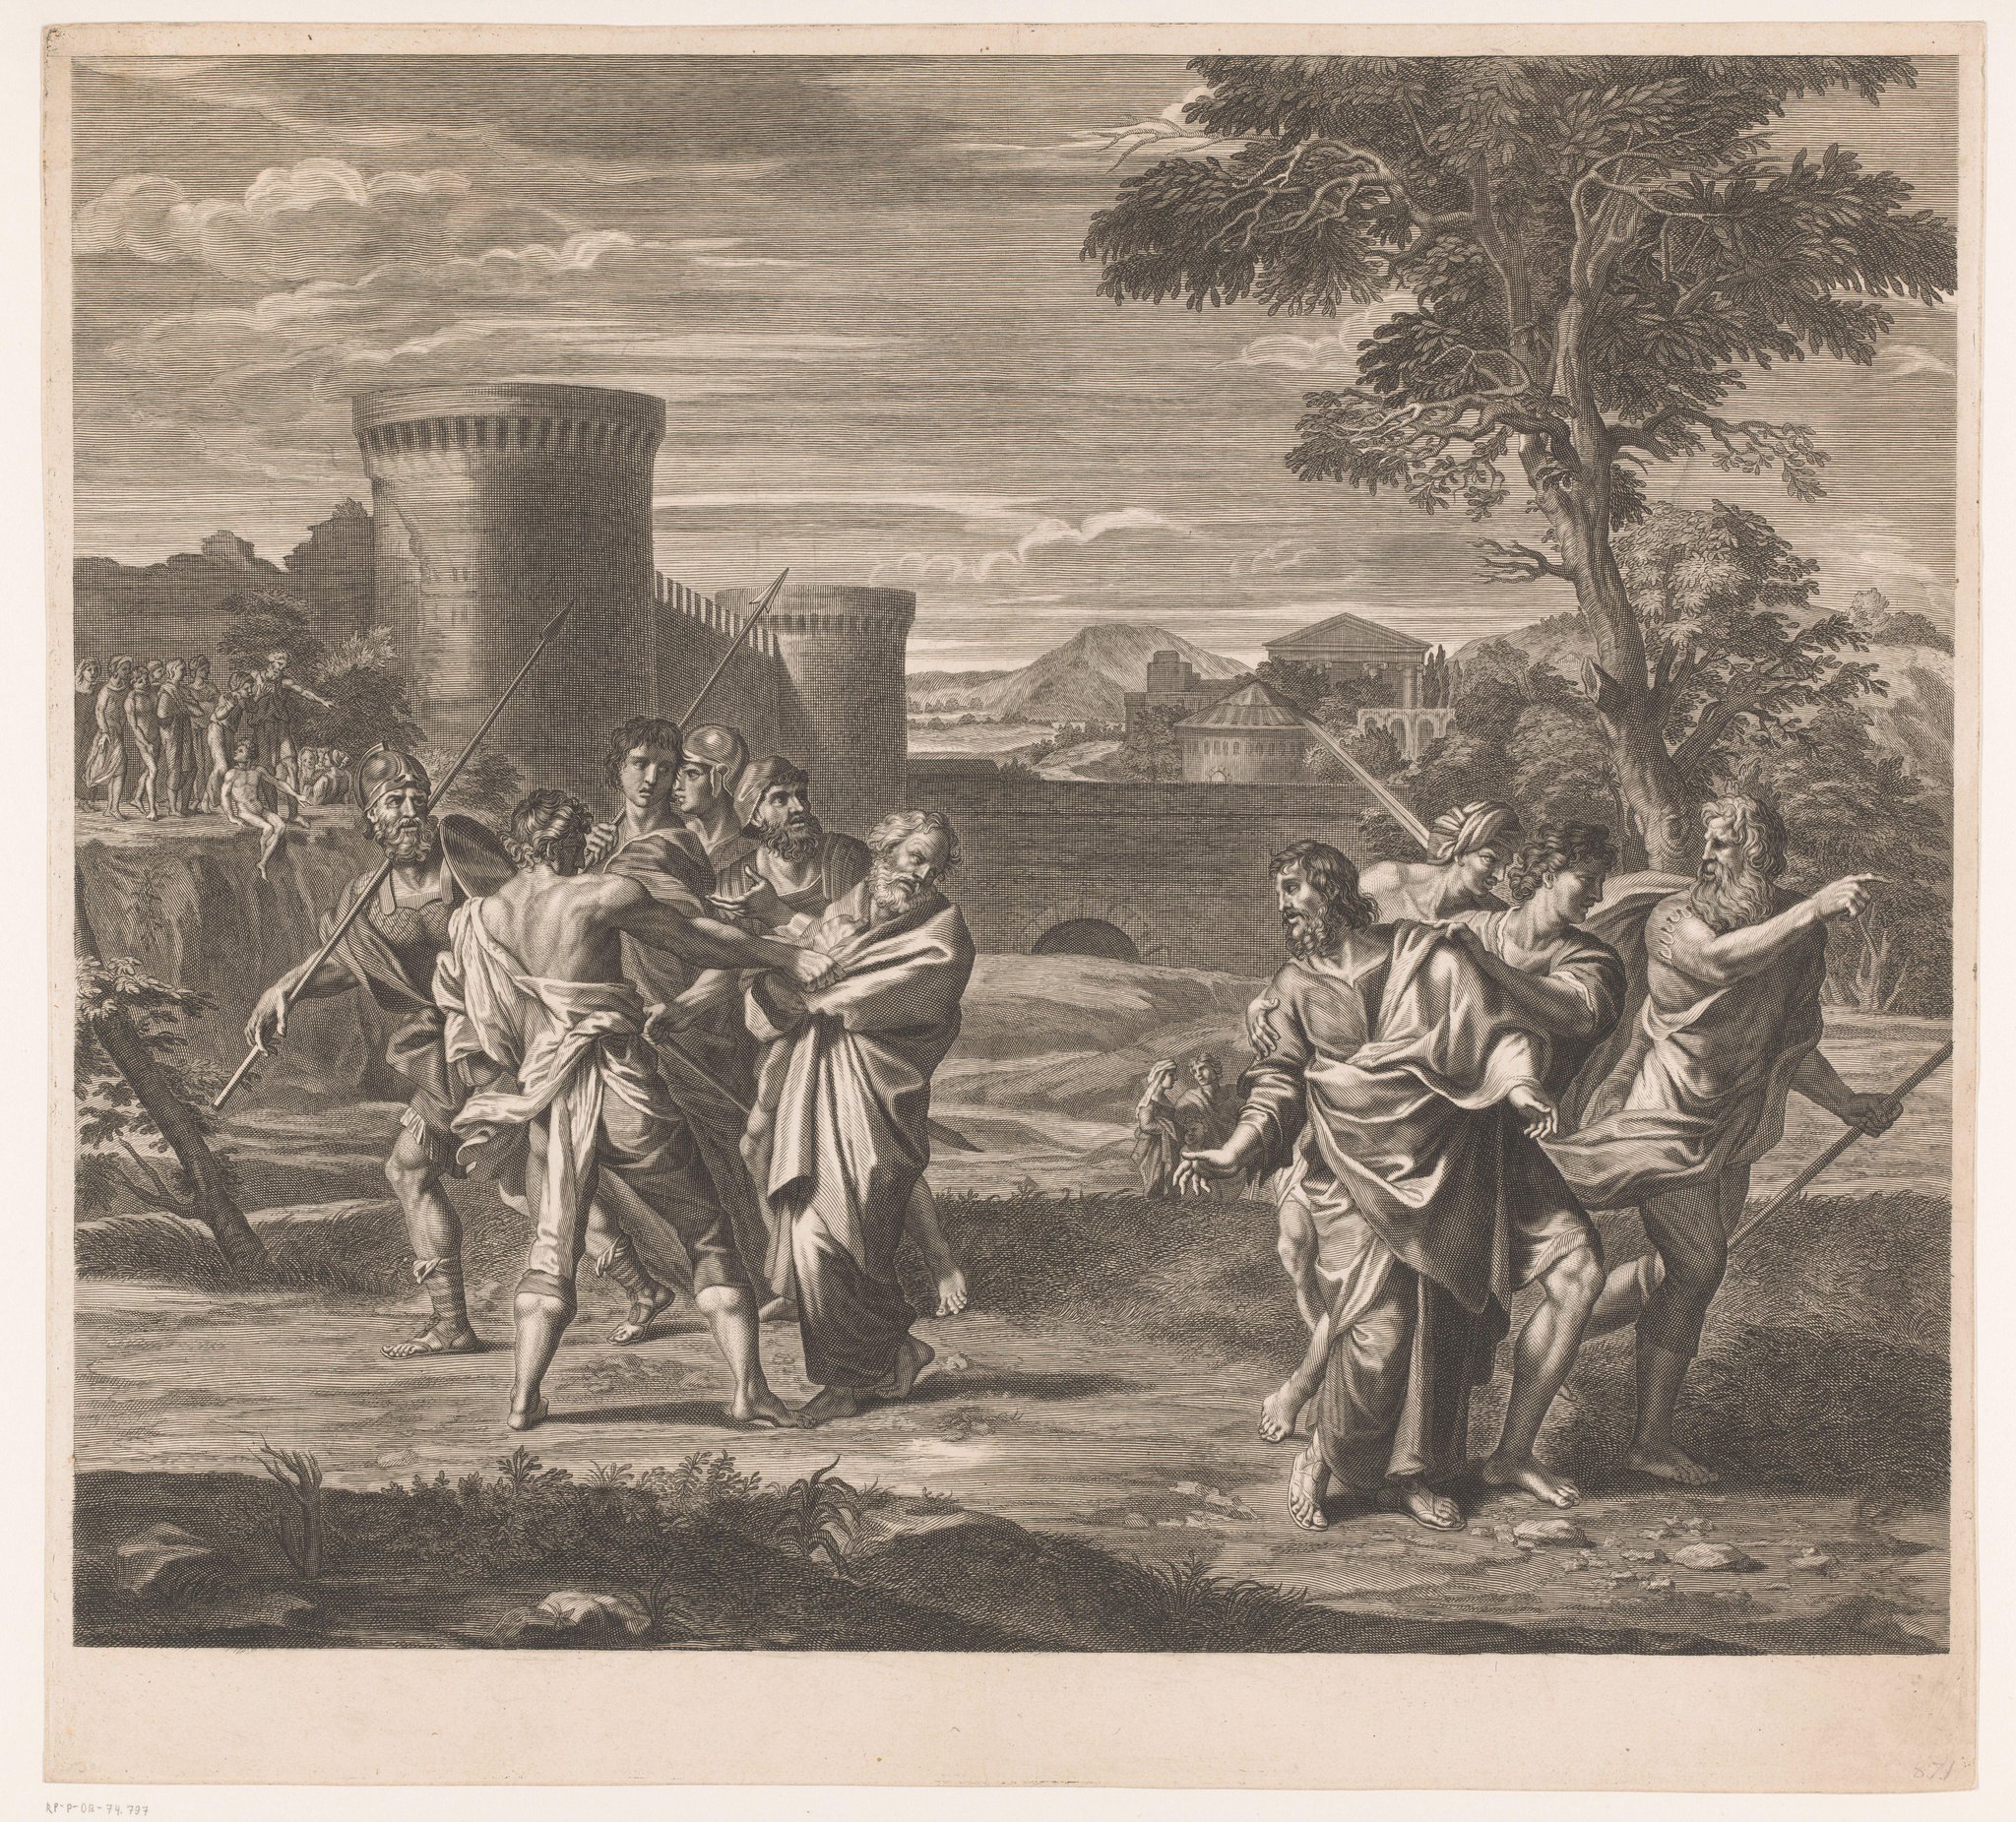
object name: print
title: Twee mannen door soldaten en anderen uit elkaar gehaald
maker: Anonymous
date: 1650-1700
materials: paper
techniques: engraving, etching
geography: france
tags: hand-to-hand fighting (~ battle)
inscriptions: collector's mark: Lugt 240